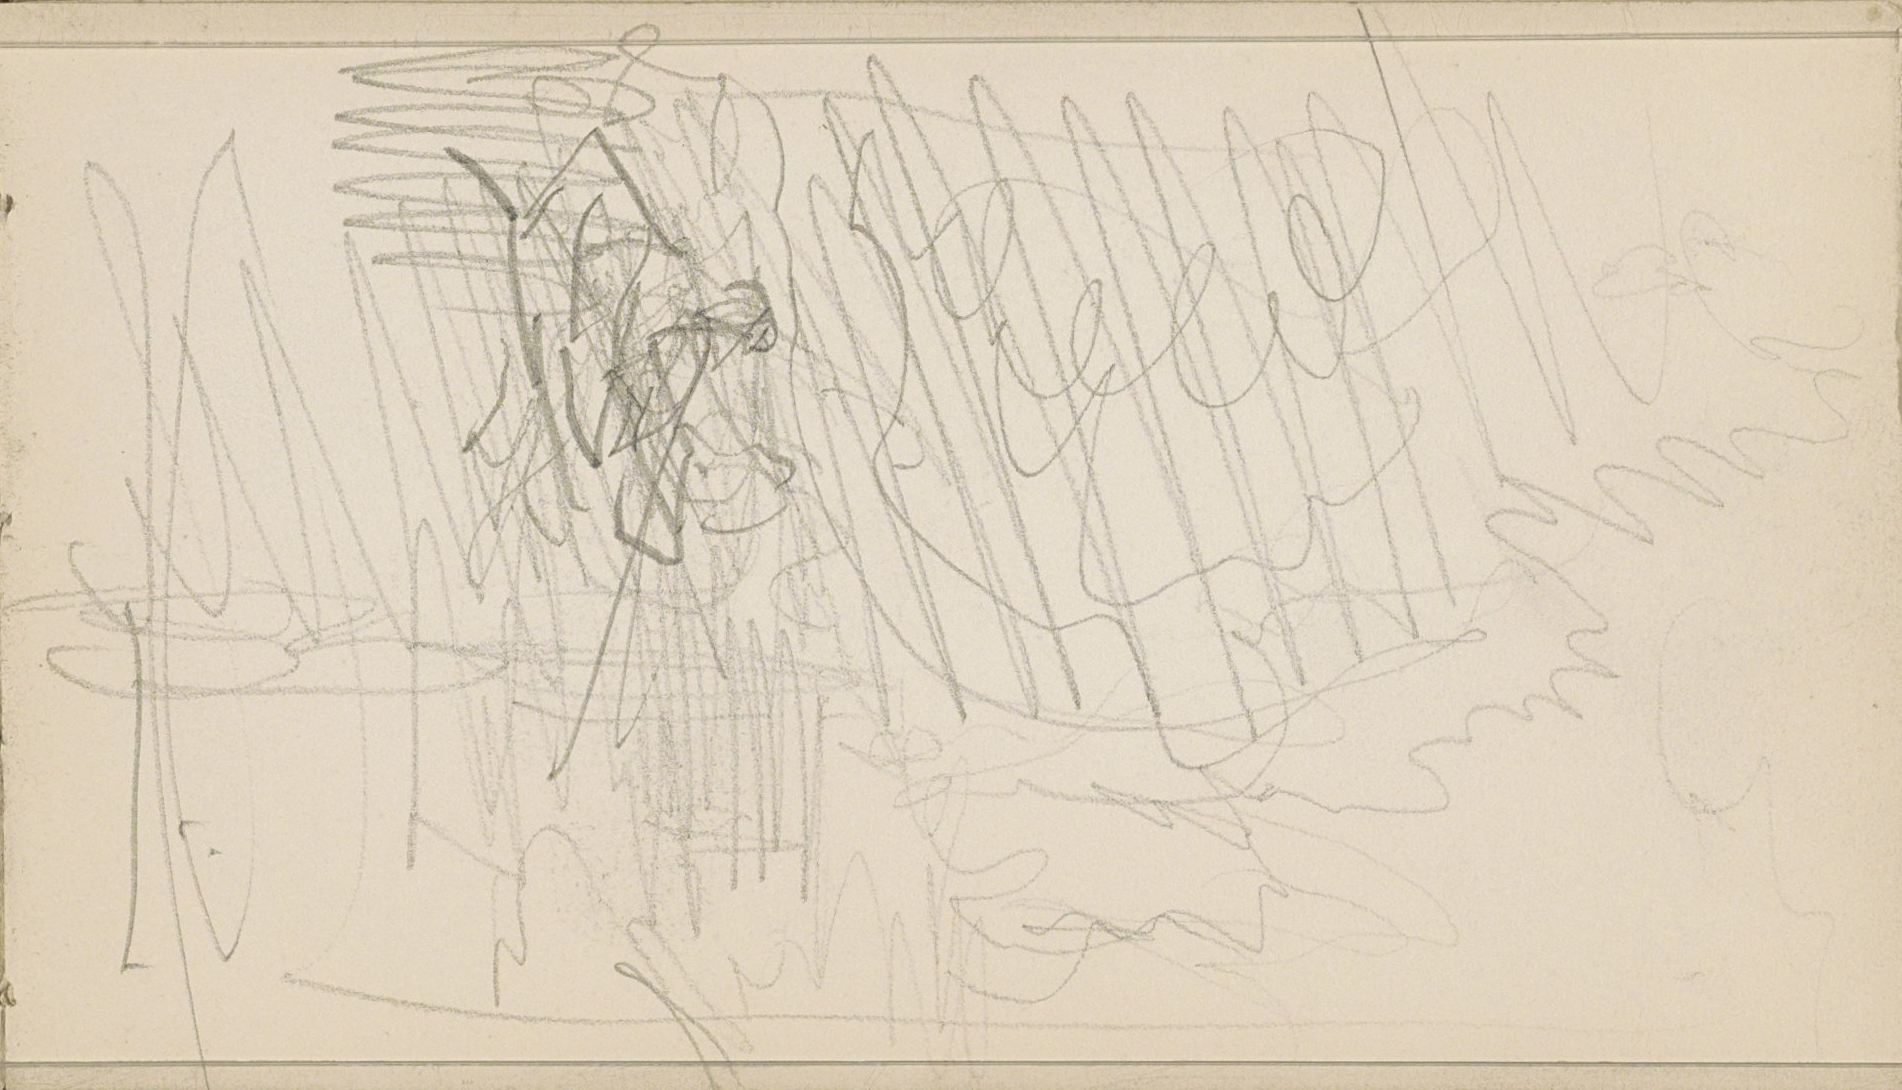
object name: sketchbook leaf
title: Studie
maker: anton mauve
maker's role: draughtsman, painter, print maker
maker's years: 1838-1888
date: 1876-1879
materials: paper, pencil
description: Blad 26 recto uit een schetsboek met 33 bladen.